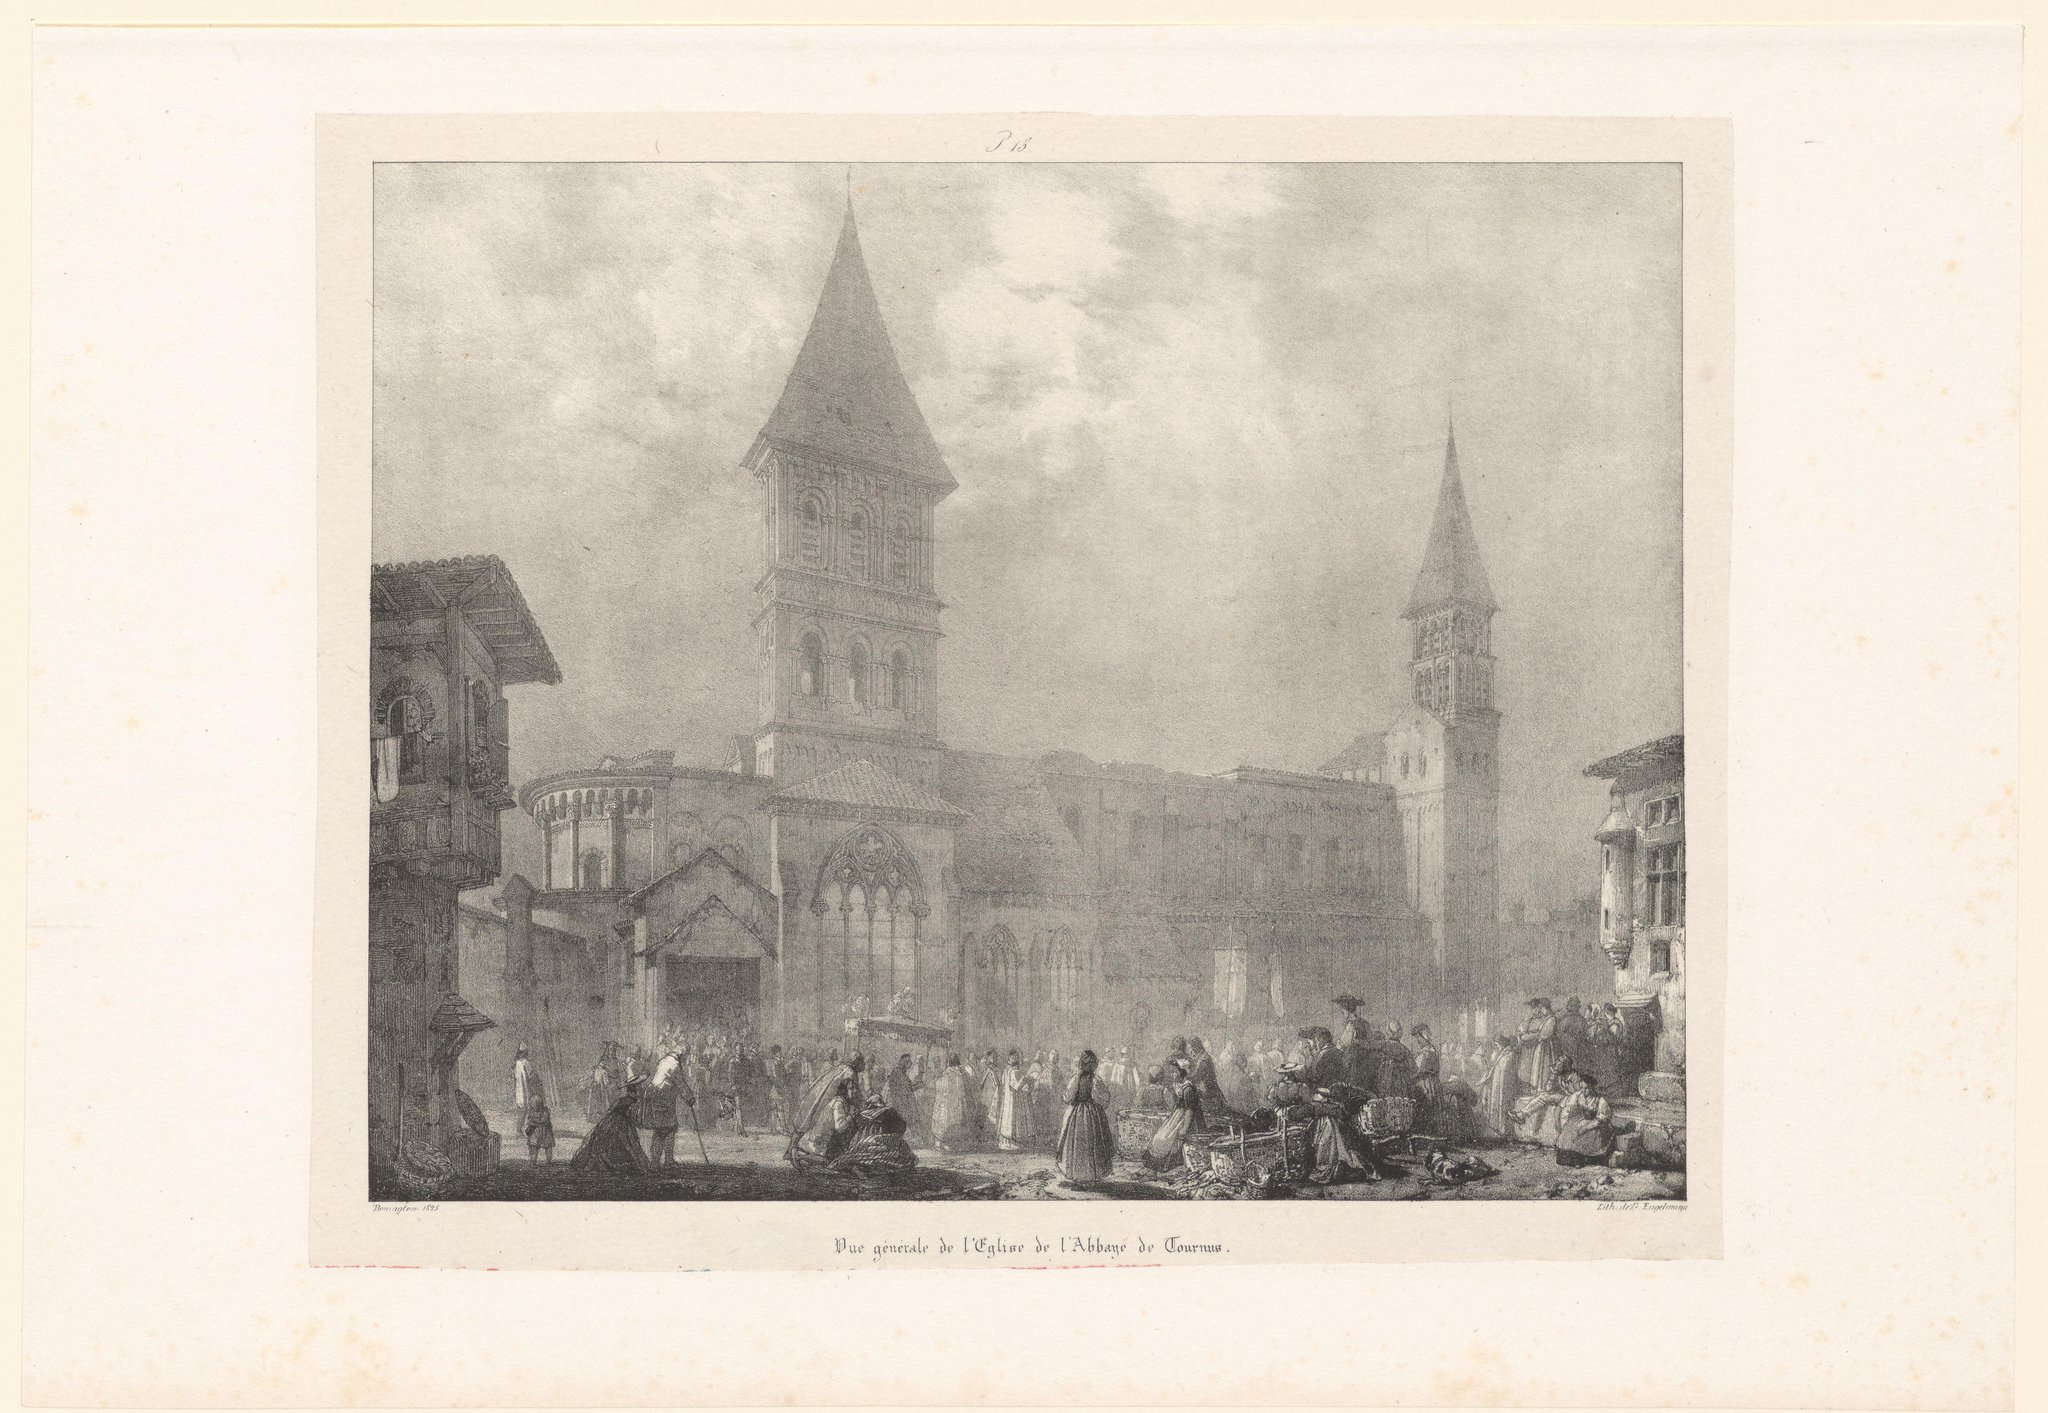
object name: print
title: Voyages pittoresques et romantiques dans l'ancienne France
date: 1825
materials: paper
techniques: lithograph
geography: paris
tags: church (exterior), procession ~ christian religion, france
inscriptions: collector's mark: Lugt 2228, collector's mark: Lugt 1463a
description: Deze prent behoort tot de serie 'Voyages pittoresques et romantiques dans l'ancienne France'. De serie is uitgevoerd onder leiding van Isidore Justin Séverin baron Taylor en bevat begeleidende teksten van Charles Nodier en Alphonse de Cailleux. Voor het project zijn vele kunstenaars naar delen van Frankrijk afgereisd. De reeks is tussen 1821 en 1878 in ca. 21 delen gepubliceerd.